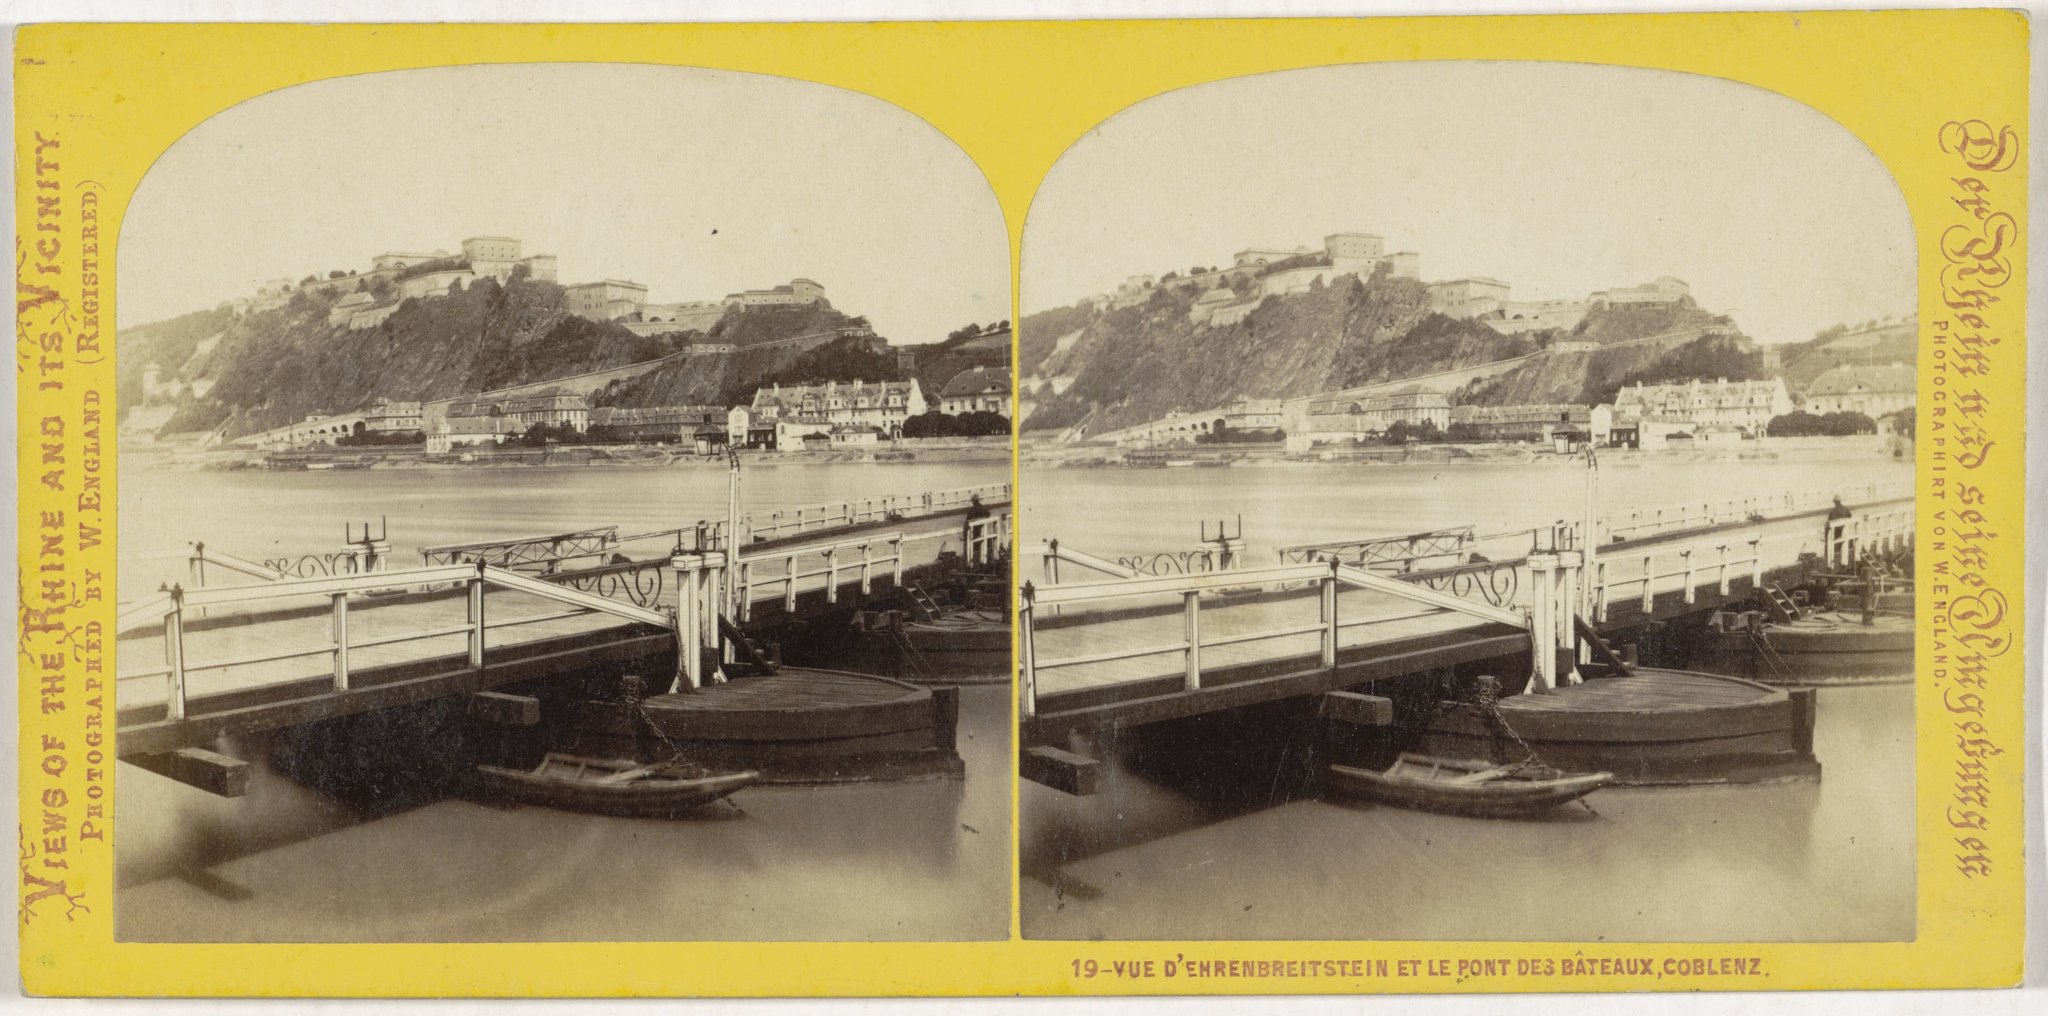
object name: stereograph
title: Vue d'Ehrenbreitstein et le pont des bâteaux, Coblenz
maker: william england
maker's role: fotograaf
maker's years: 1816-1896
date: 1867-1868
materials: cardboard, paper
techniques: albumen print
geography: koblenz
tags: river, landscape with tower or castle, pontoon bridge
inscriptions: inscription: ‘(Registered)’, number: ‘19’